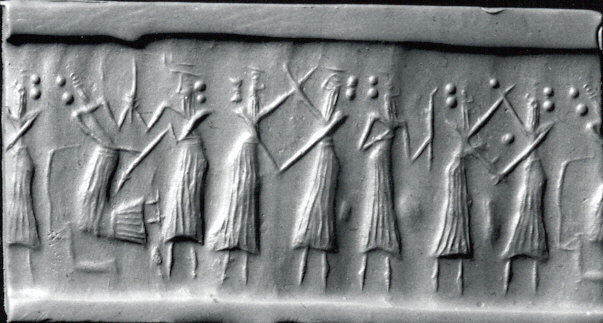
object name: cylinder seal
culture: akkadian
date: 2350-2150 BCE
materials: stone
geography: mesopotamia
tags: women